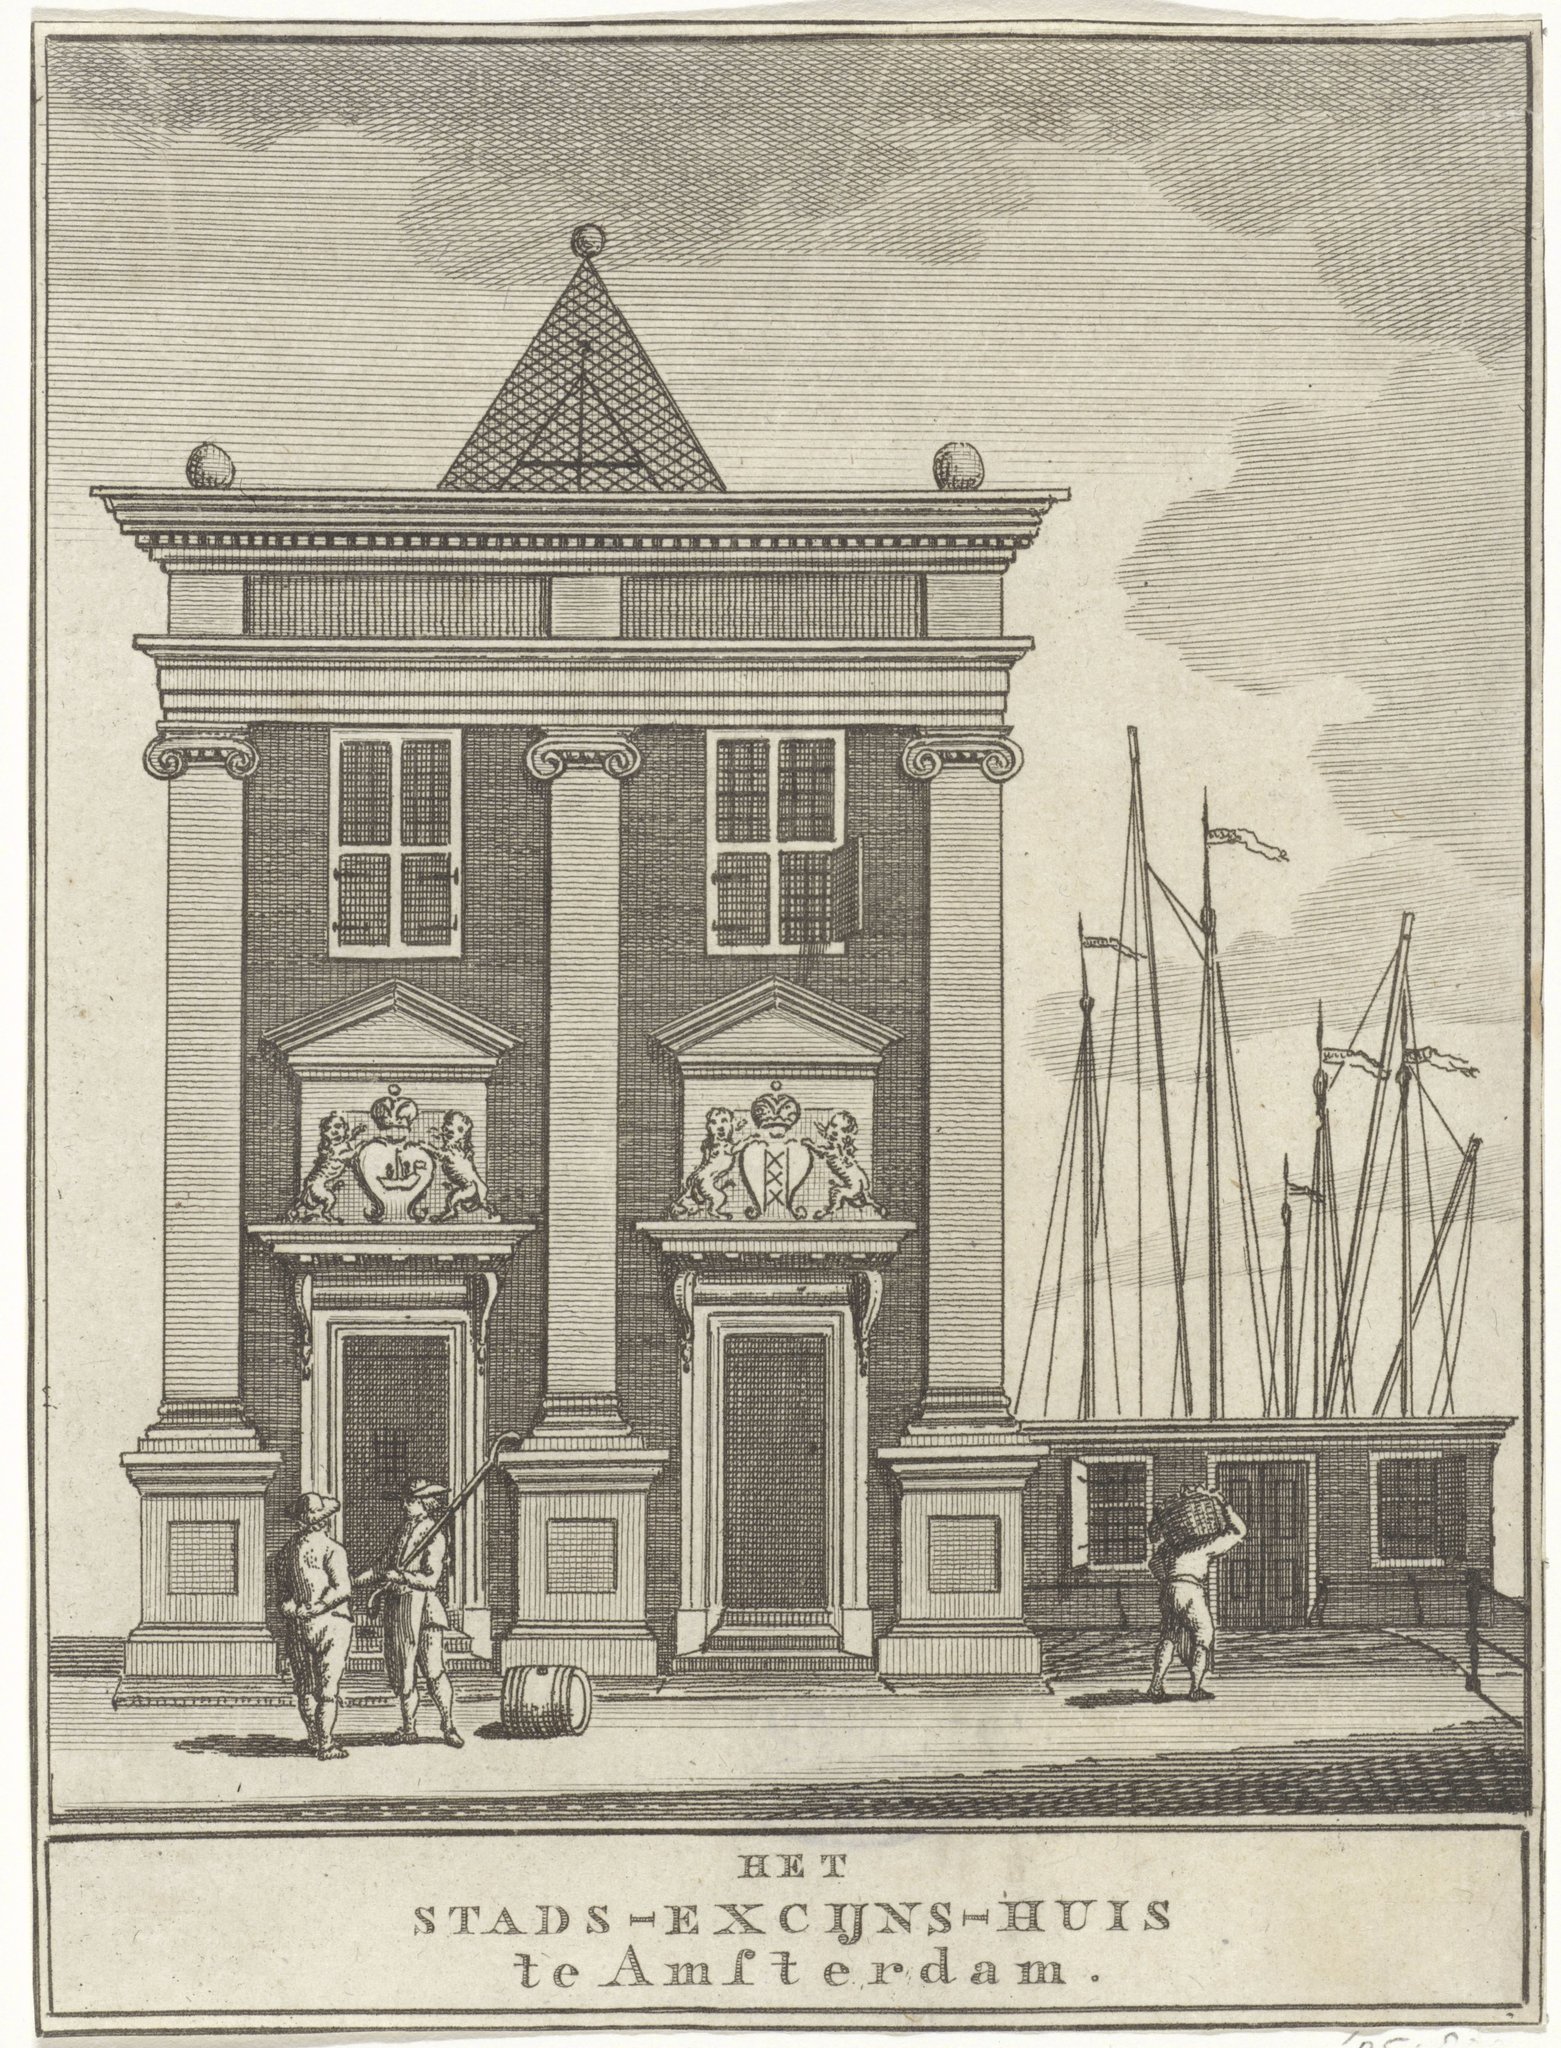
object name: book illustration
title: Accijnshuis te Amsterdam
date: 1705-1794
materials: paper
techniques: engraving, etching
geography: amsterdam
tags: accijnshuis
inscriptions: collector's mark: Lugt 2228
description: Prent uit: De maandelykse Nederlandsche Mercurius, geevende een volledig bericht van alles, wat'er aanmerkenswaardig ieder maand, in Europa is voorgevallen. Amsterdam: J.A. Swalm, 1794.